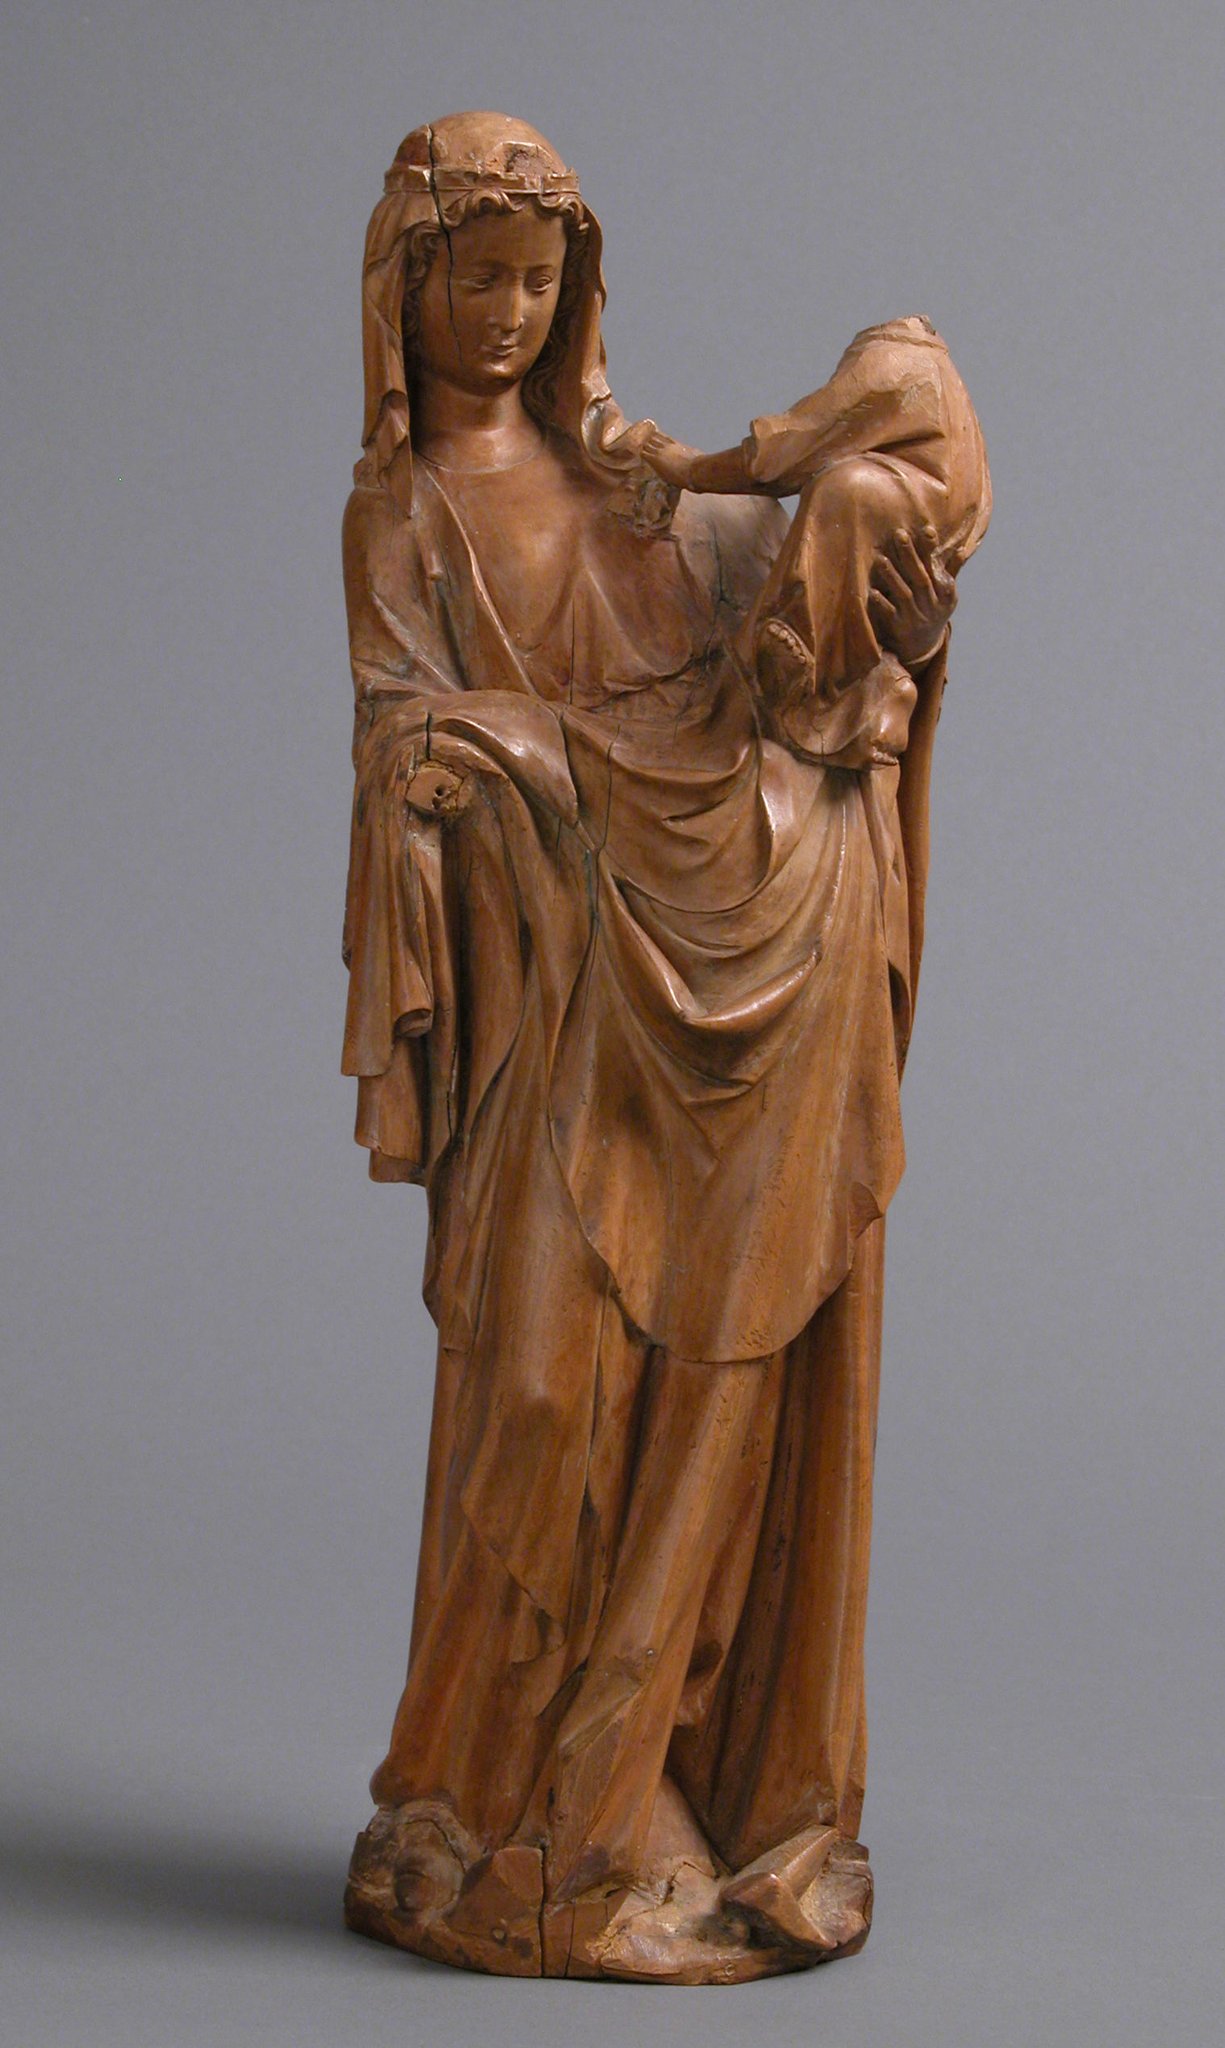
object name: statuette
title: Virgin and Child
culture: french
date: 1334-1366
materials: wood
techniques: polychromy